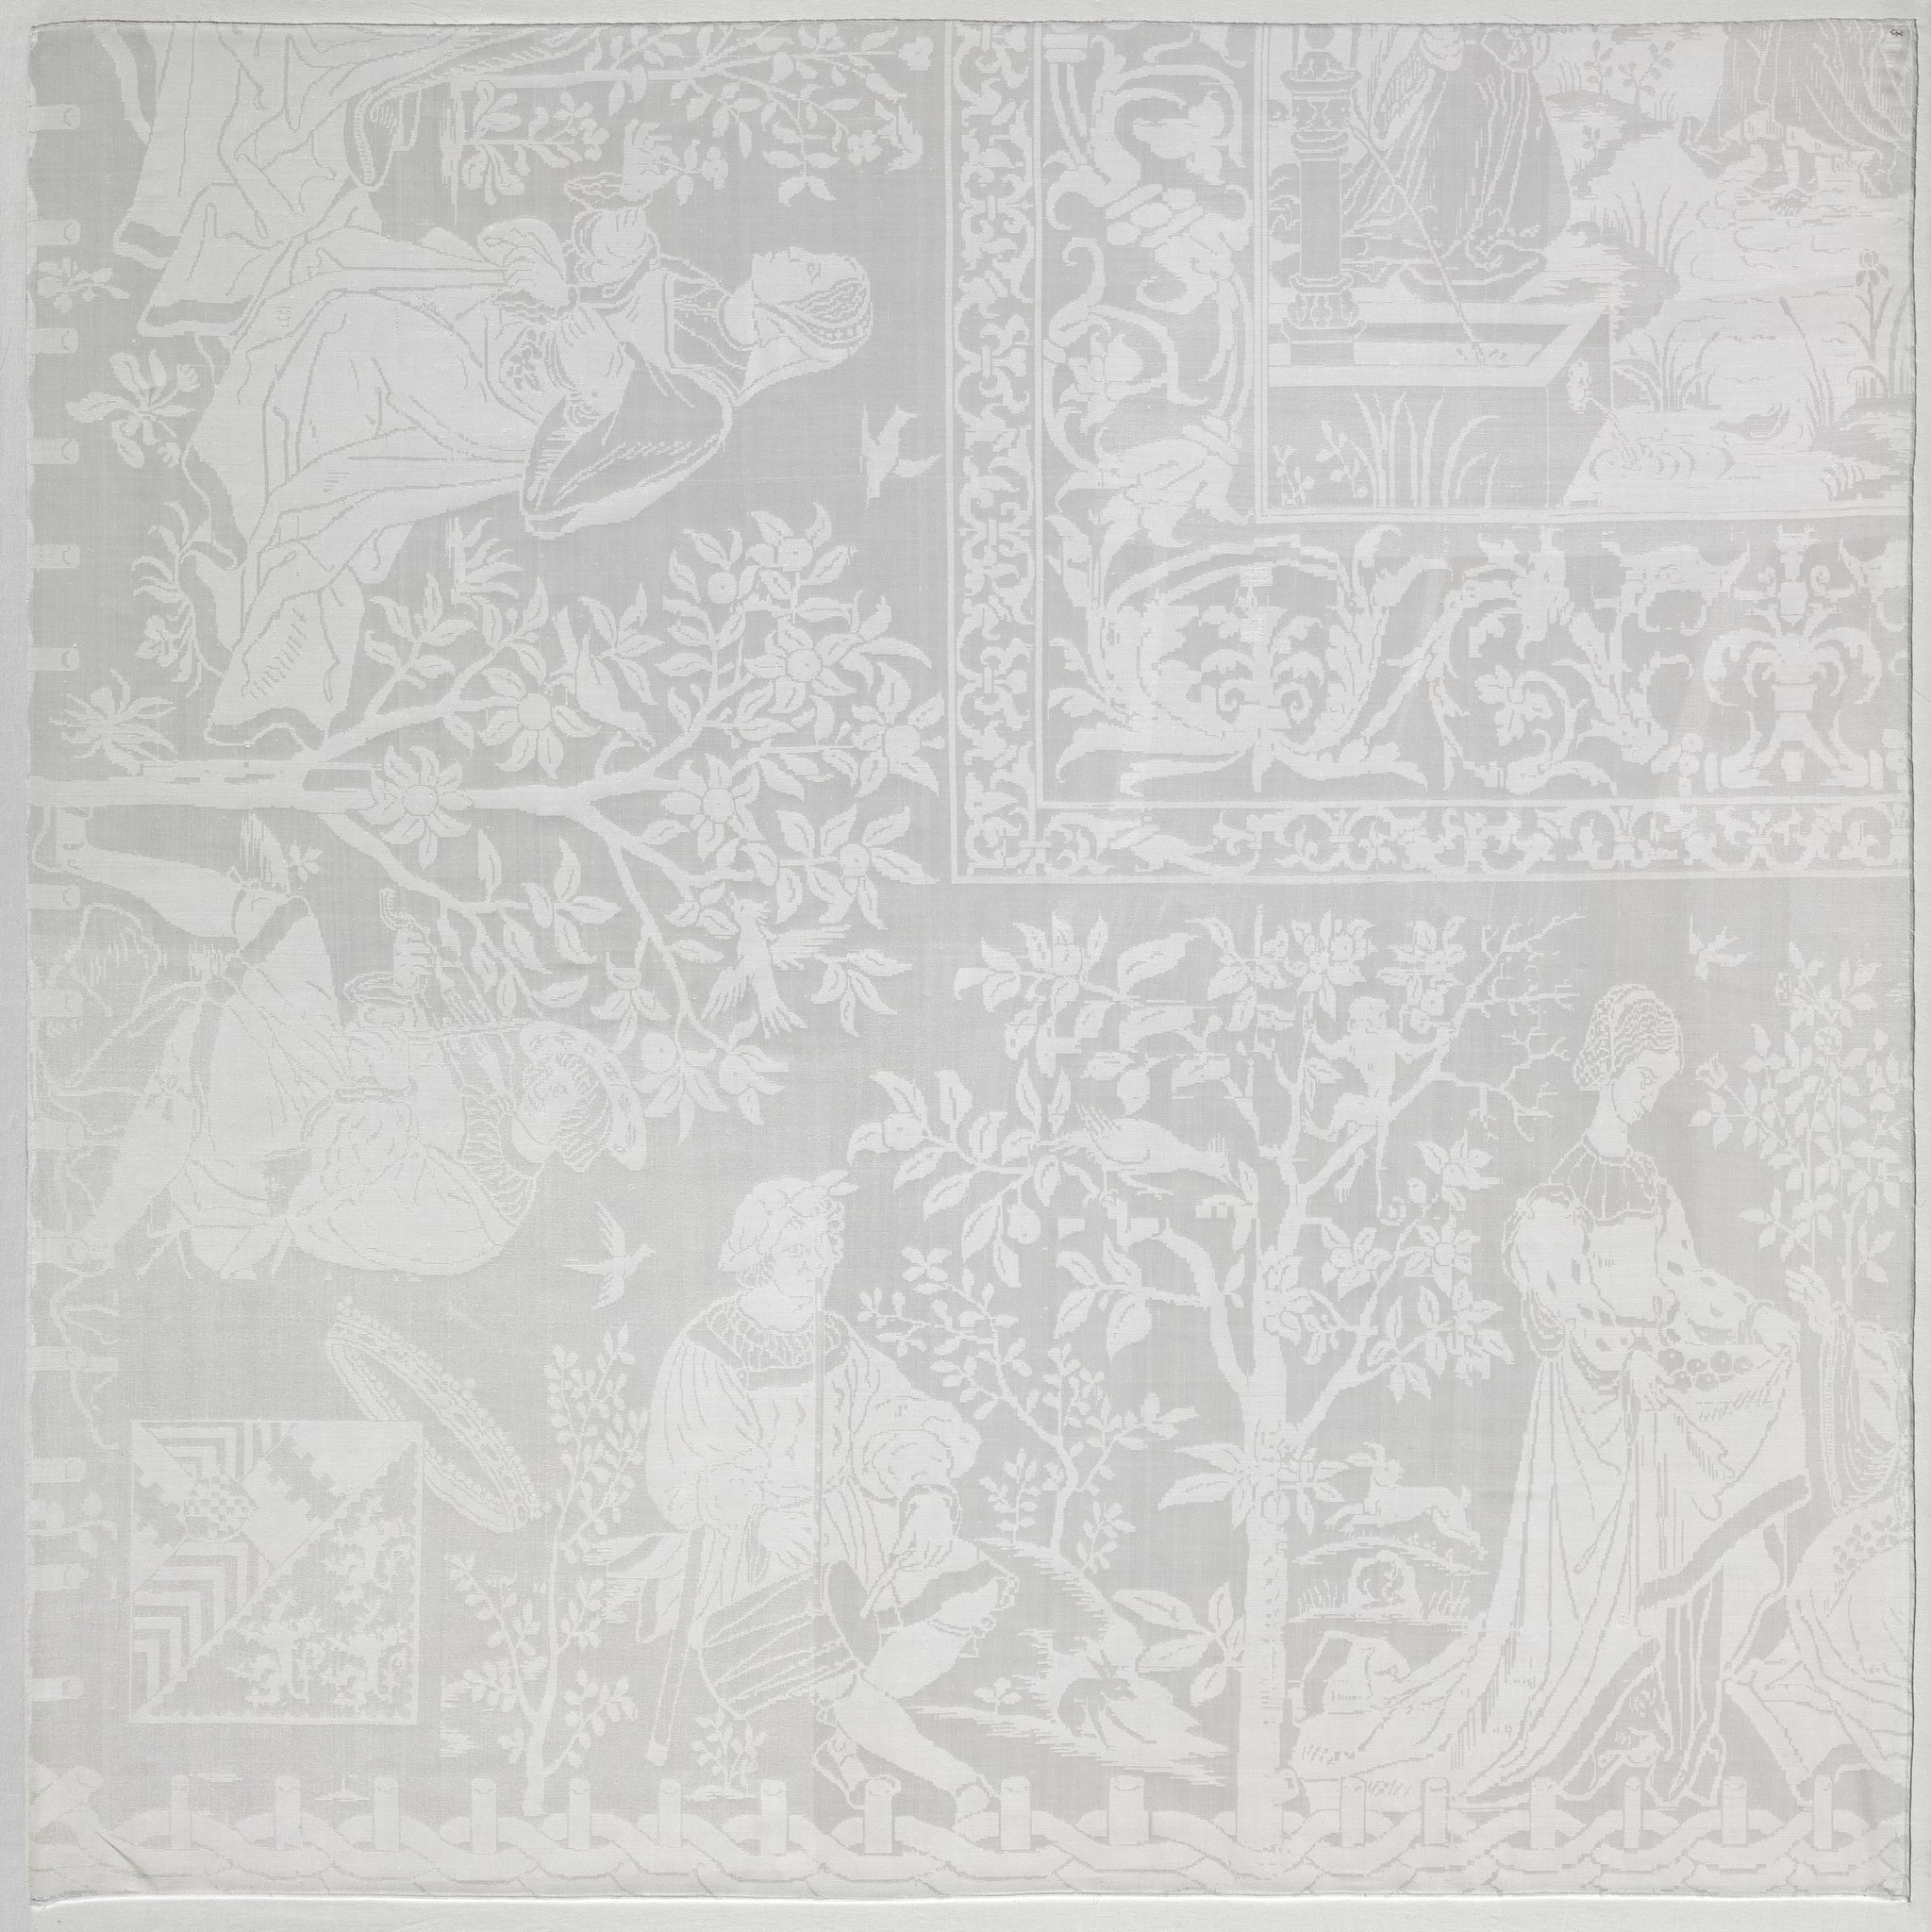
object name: fragment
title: Fragment van een tafellaken van linnendamast, voorstelling: geschiedenis van Susanna; rand met muzikanten en vrouwen, in de hoek het wapen van Egmond-Lannoy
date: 1531-1540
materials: linen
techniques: damask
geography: southern netherlands